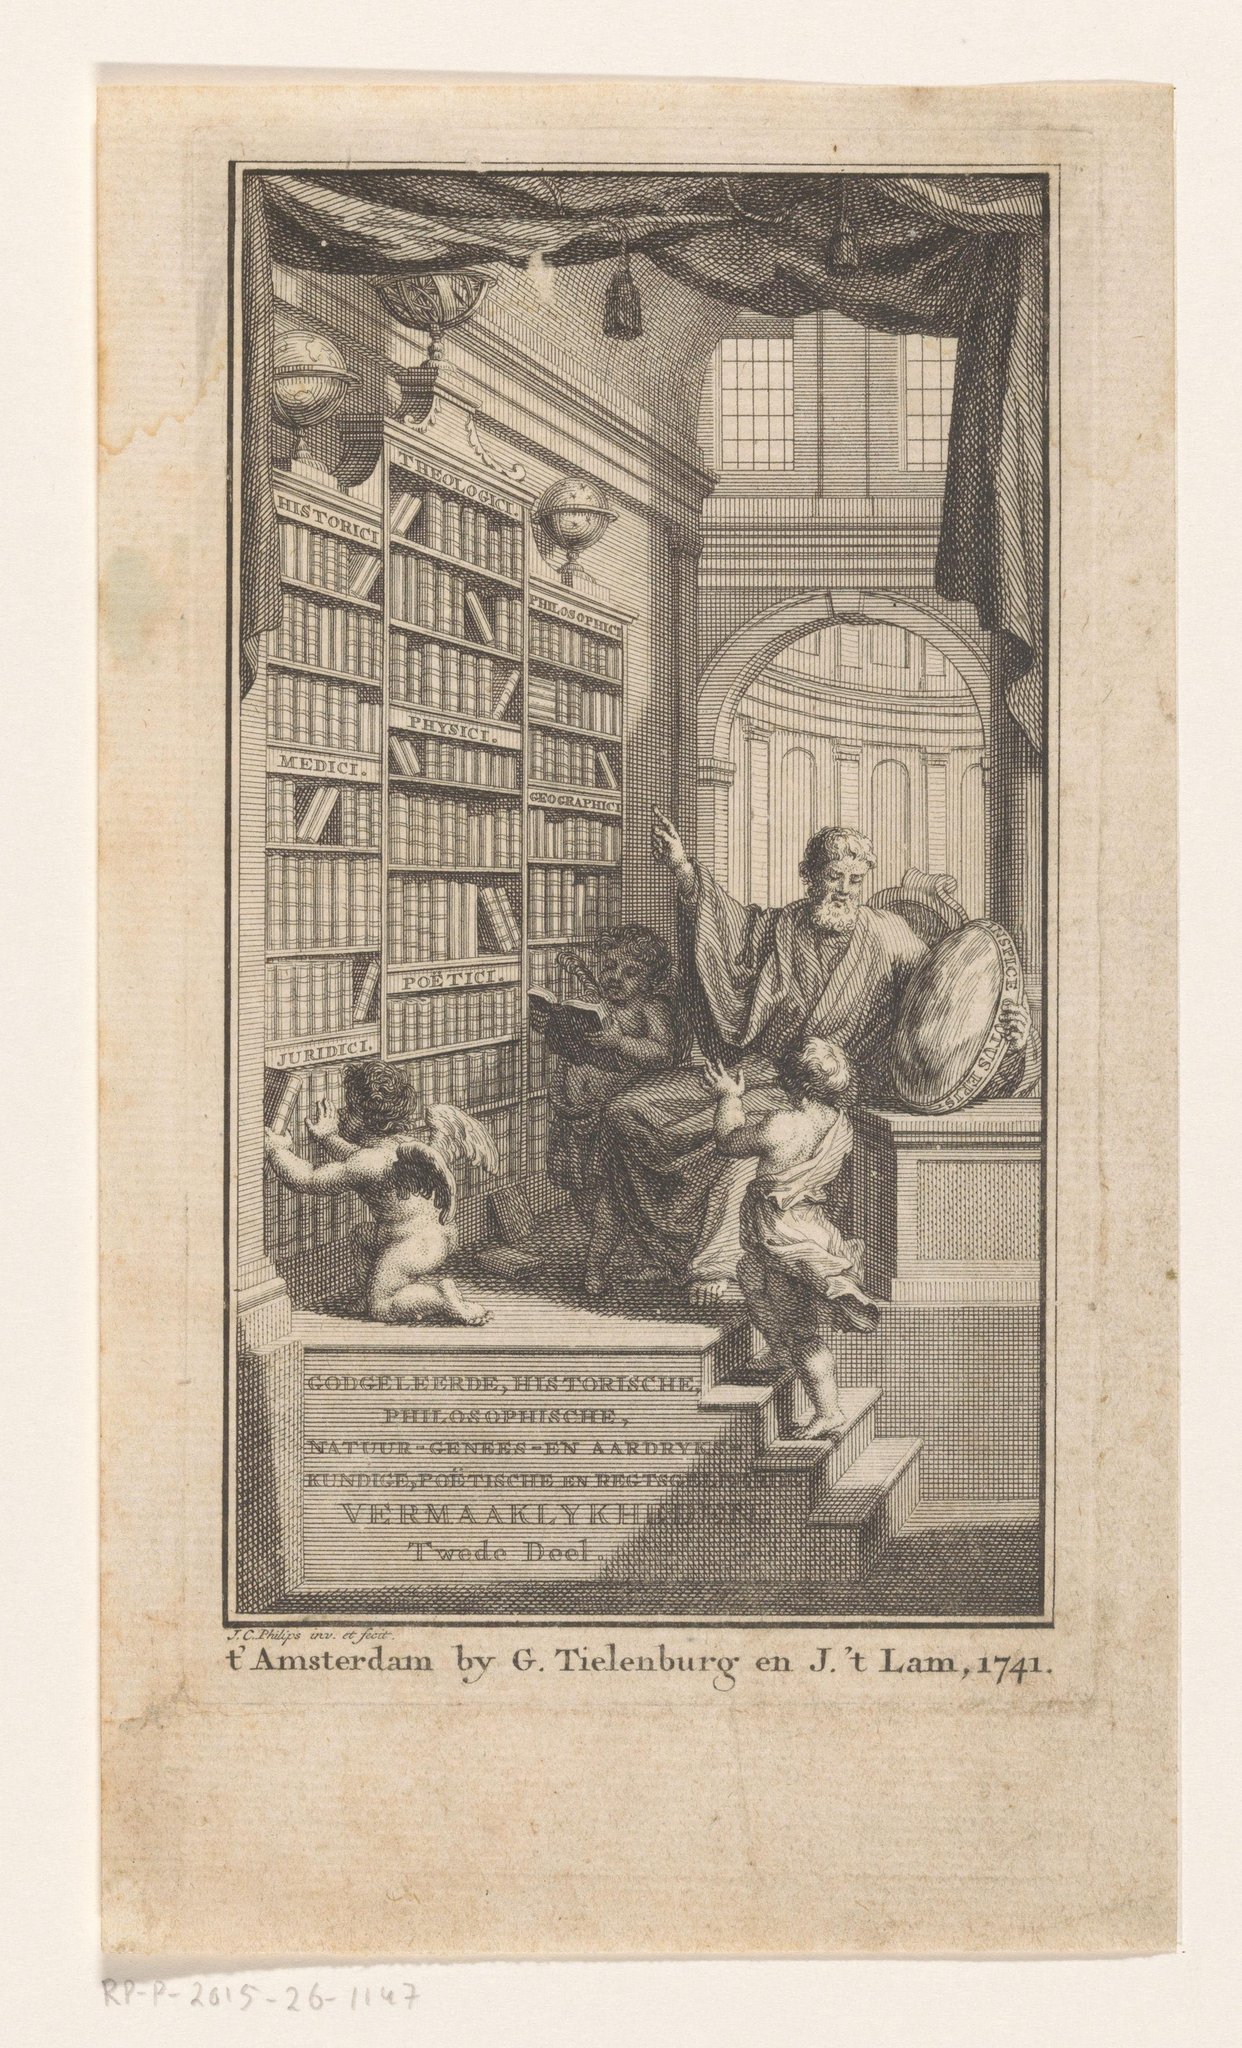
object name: titelblad, titelpagina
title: Titelpagina voor: Godgeleerde, historische, philosophische ((...)) poëtische en regtsgeleerde vermakelykheden, 1741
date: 1741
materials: paper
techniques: etching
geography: amsterdam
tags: bookshelves, symbolic representations, allegories and emblems ~ education; 'ammaestramento', dottrina', 'educatione', 'istitutione' (ripa), cupids: 'amores', 'amoretti', 'putti'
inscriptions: : Lugt 4780, collector's mark: Lugt 2228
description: Prent gebruikt als titelpagina voor: Godgeleerde, historische, philosophische, natuur-genees-en aerdrykskundige, poëtische en regtsgeleerde vermakelykheden. Dl. 2. Amsterdam: G. Tielenburg en J. 't Lam, 1741.